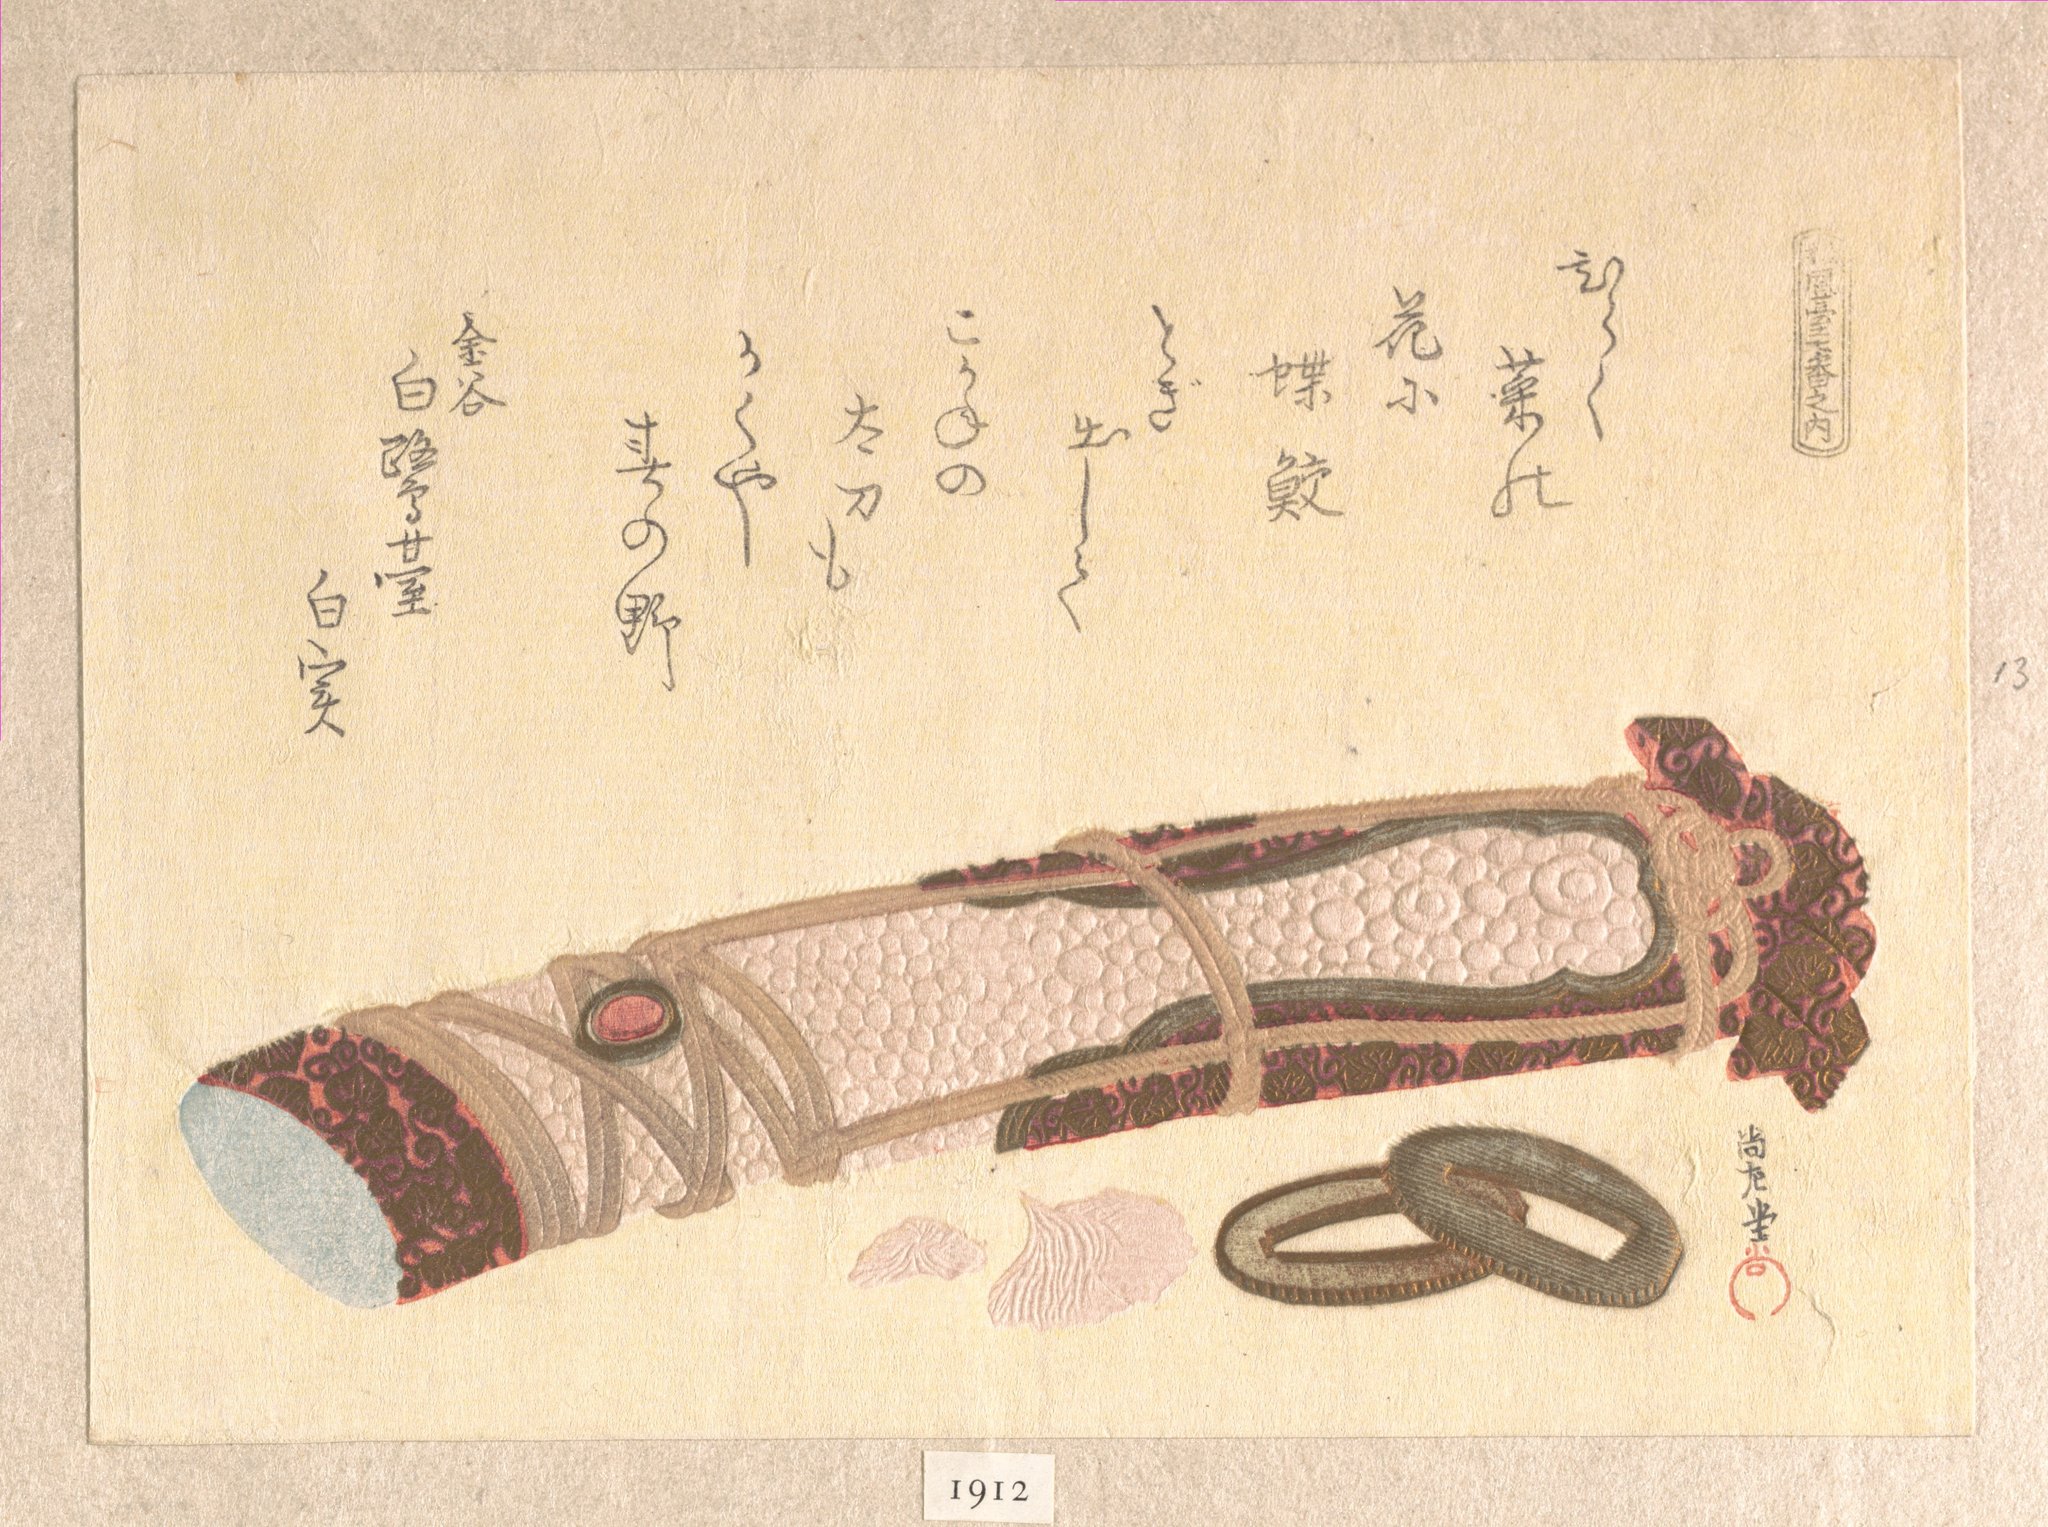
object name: print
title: “Hilt of a Sword,” from the series of Seven Prints for the Shōfudai Poetry Circle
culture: japanese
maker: kubo shunman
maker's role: artist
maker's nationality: japanese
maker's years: 1757-1820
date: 1810-1819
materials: ink, paper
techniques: surimono, woodblock print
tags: hilts